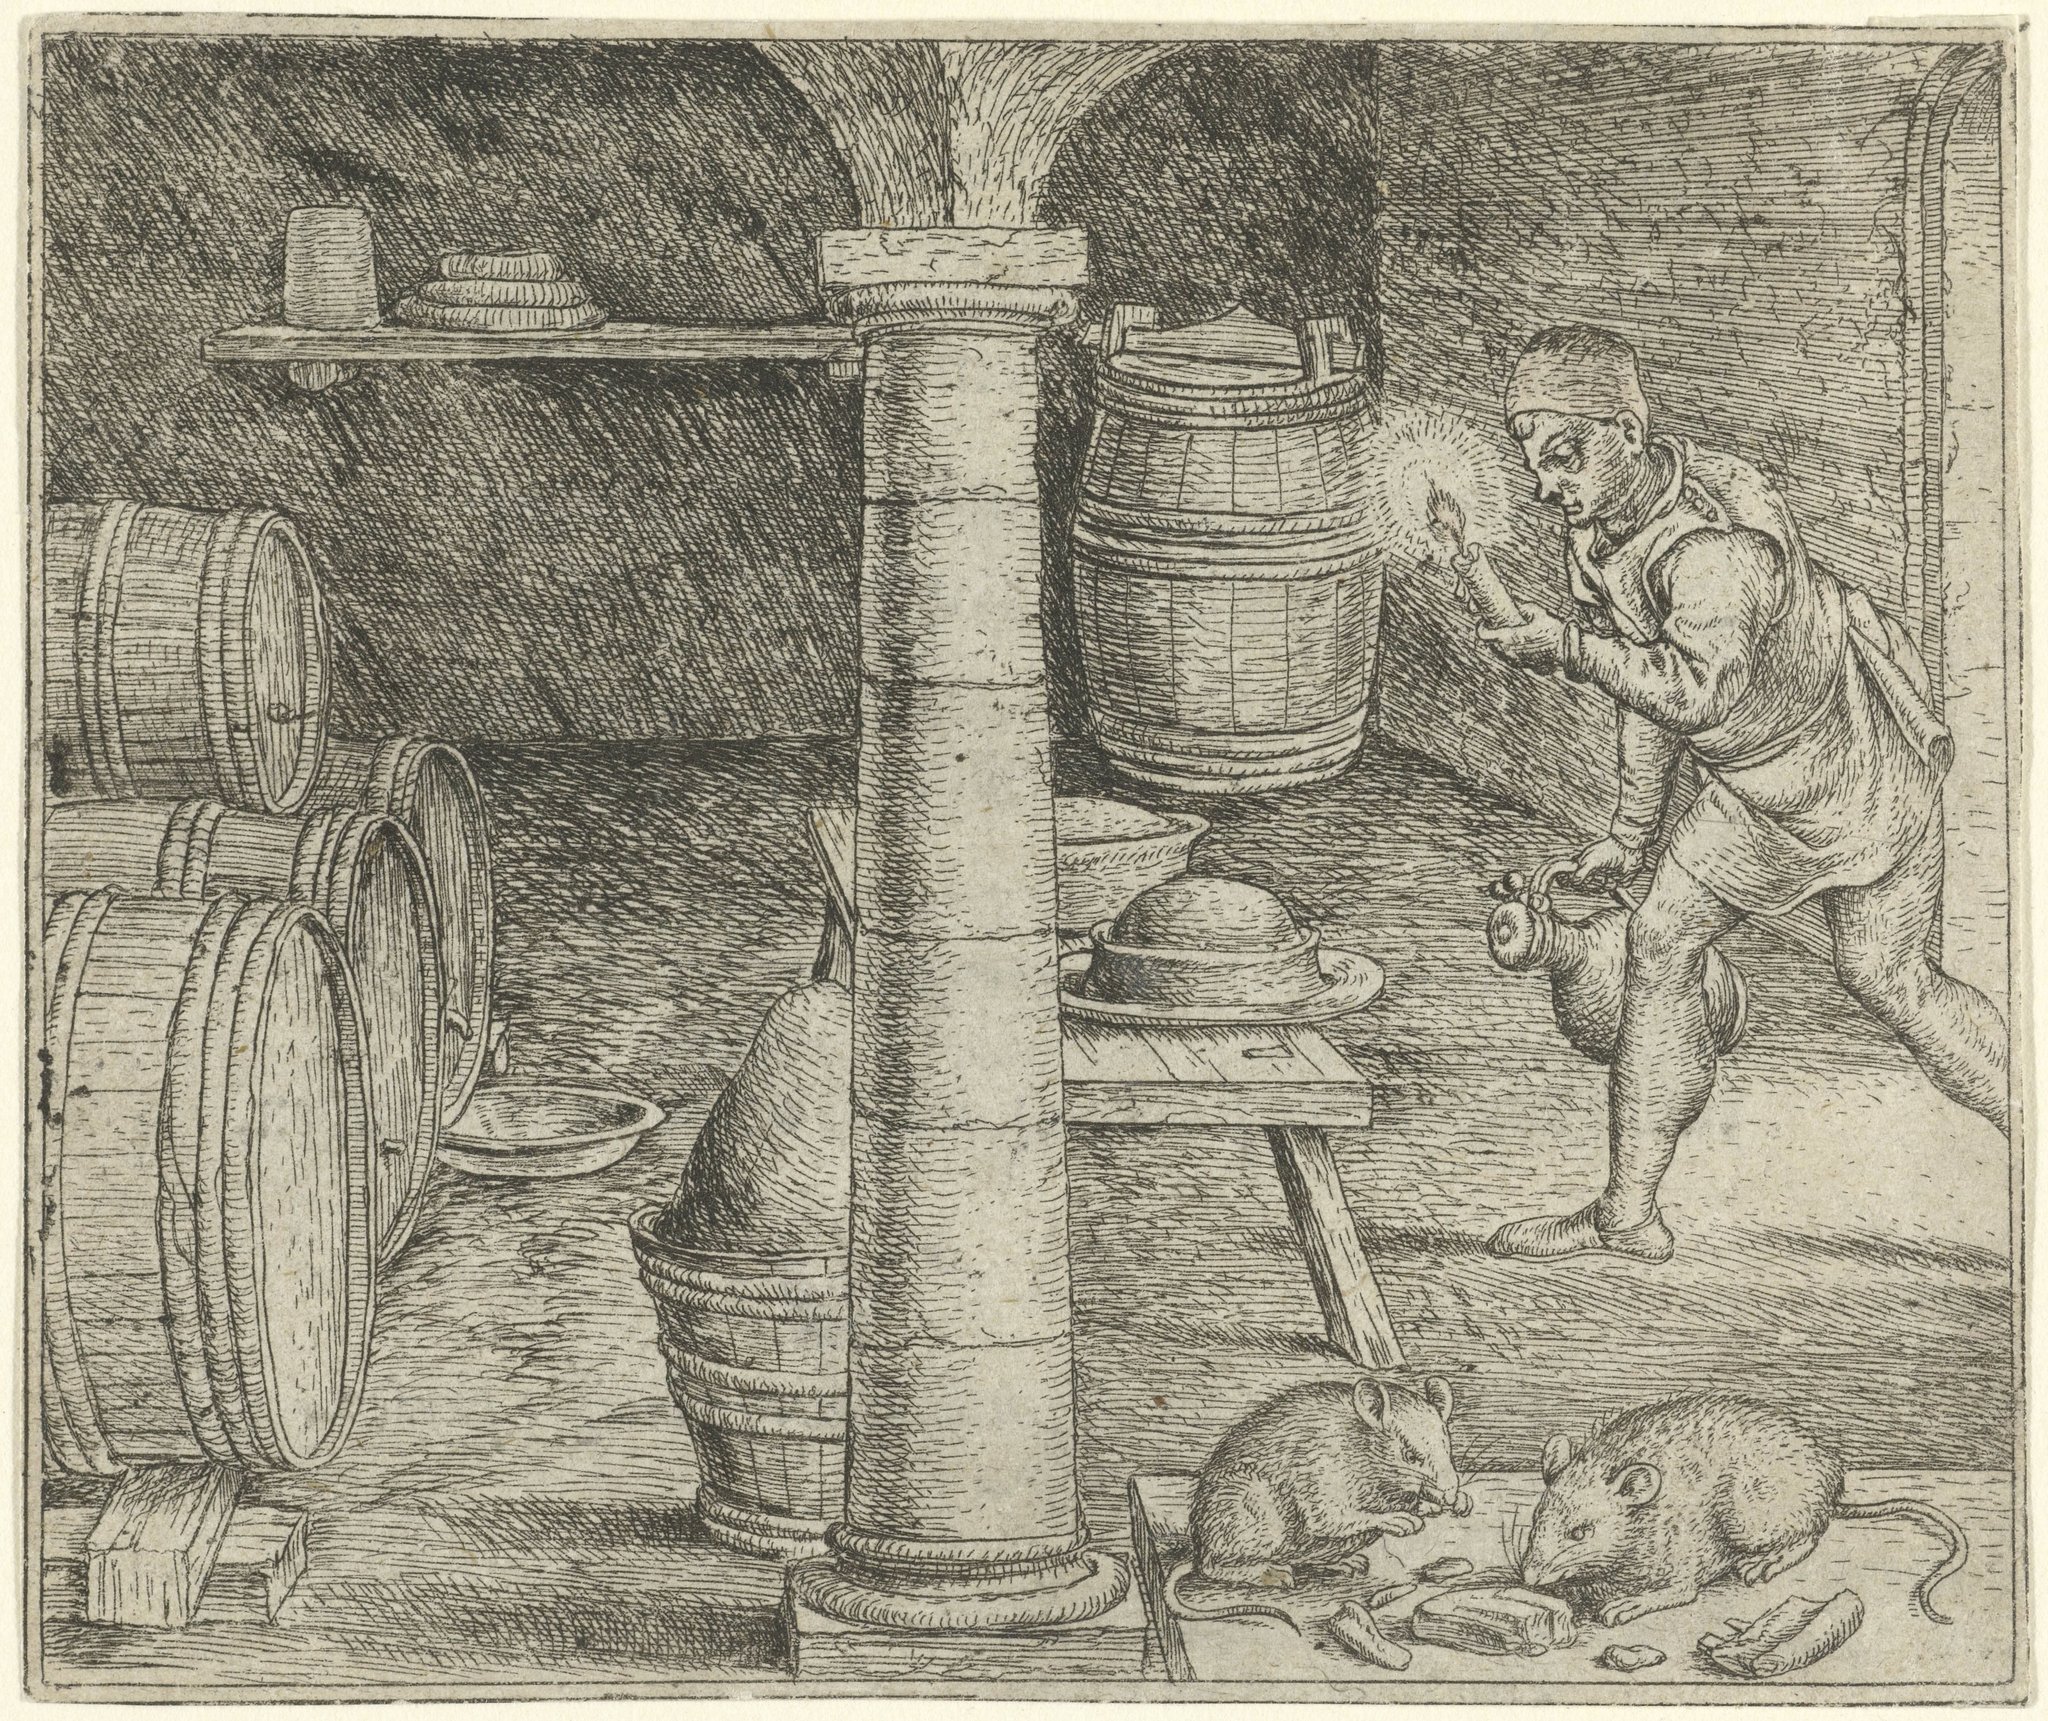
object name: book illustration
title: Fabel van de twee muizen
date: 1567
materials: paper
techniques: etching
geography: bruges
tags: rodents: mouse, cellar, fables of aesop (with title) : use 85(...)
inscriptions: collector's mark: Lugt 2228, collector's mark: Lugt 2760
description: In een kelder zitten een huismuis en een veldmuis samen op een tafel en eten voedselresten. Een man komt binnen met een kaars in zijn hand. De huismuis heeft weliswaar een overvloed aan eten, maar zijn leven is veel gevaarlijker dan dat van de veldmuis